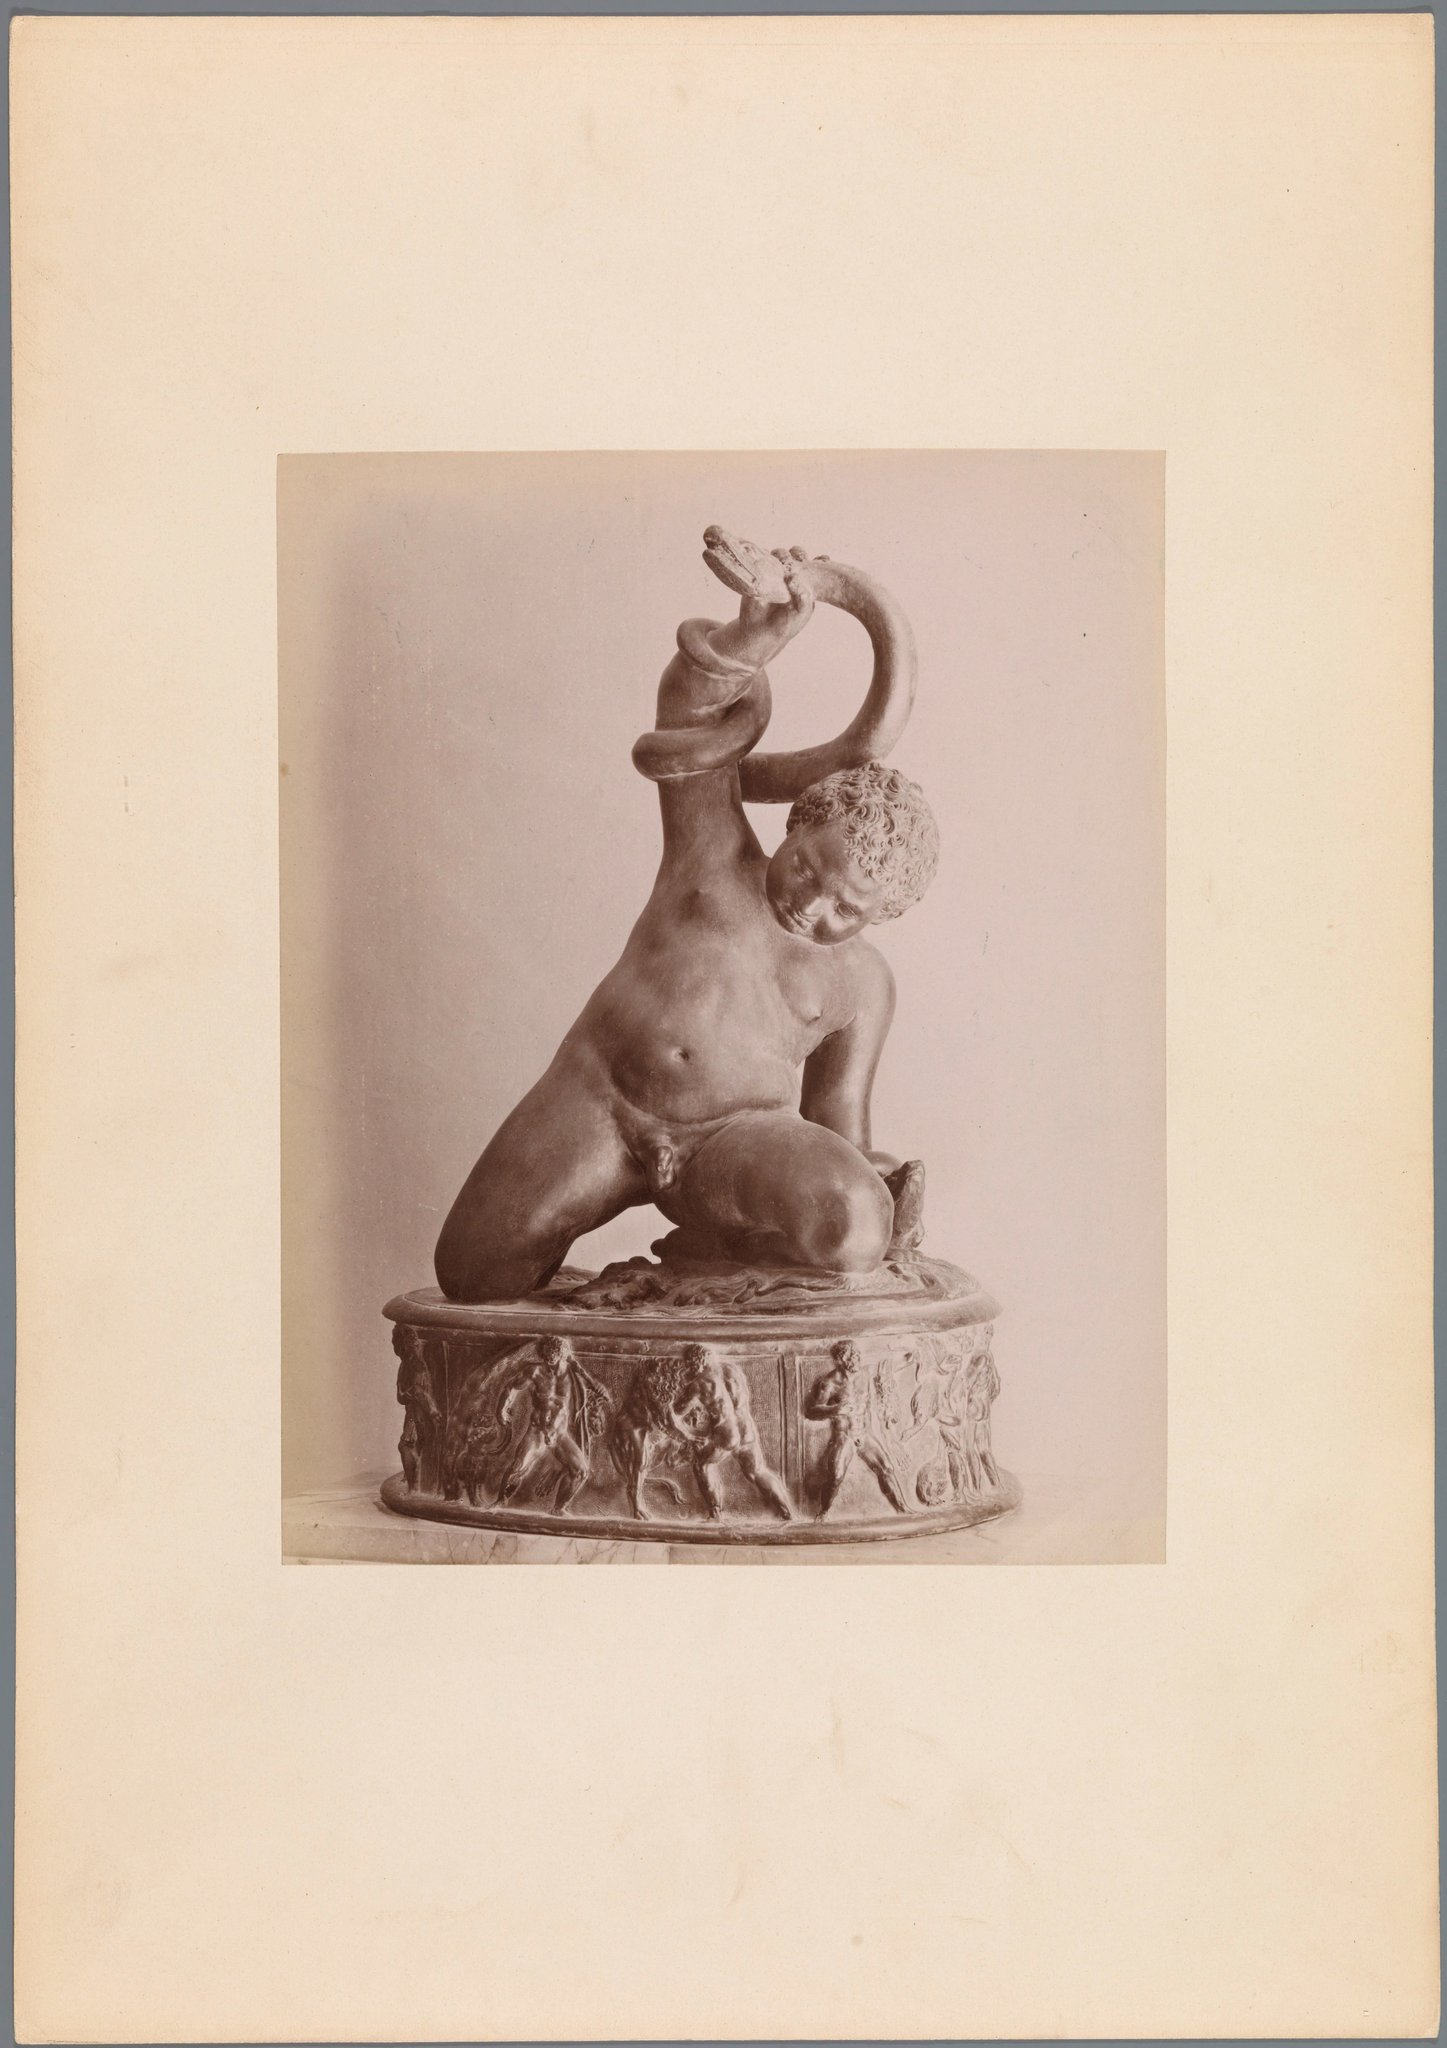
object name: photograph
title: Beeld van Herakles als kind, worstelend met twee slangen, door G. Della Porta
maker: Anonymous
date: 1875-1900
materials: cardboard, photographic support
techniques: albumen print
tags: snakes, early life, prime youth of hercules, (6) the stymphalian birds are shot by hercules, or driven away with a bronze rattle, (1) hercules chokes the nemean lion with his arms, (12) cerberus captured and carried away by hercules, sculpture, sculpture (+ relief ~ sculpture)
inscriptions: collector's mark: ‘KUNSTNIJVERHEIDSCHOOL QUELLINUS AMSTERDAM FRANS HALSSTRAAT 14.’, collector's mark: ‘INSTITUUT VOOR KUNST-NIJVERHEIDSONDERWIJS GABRIËL METSUSTRAAT No. 16. AMSTERDAM’